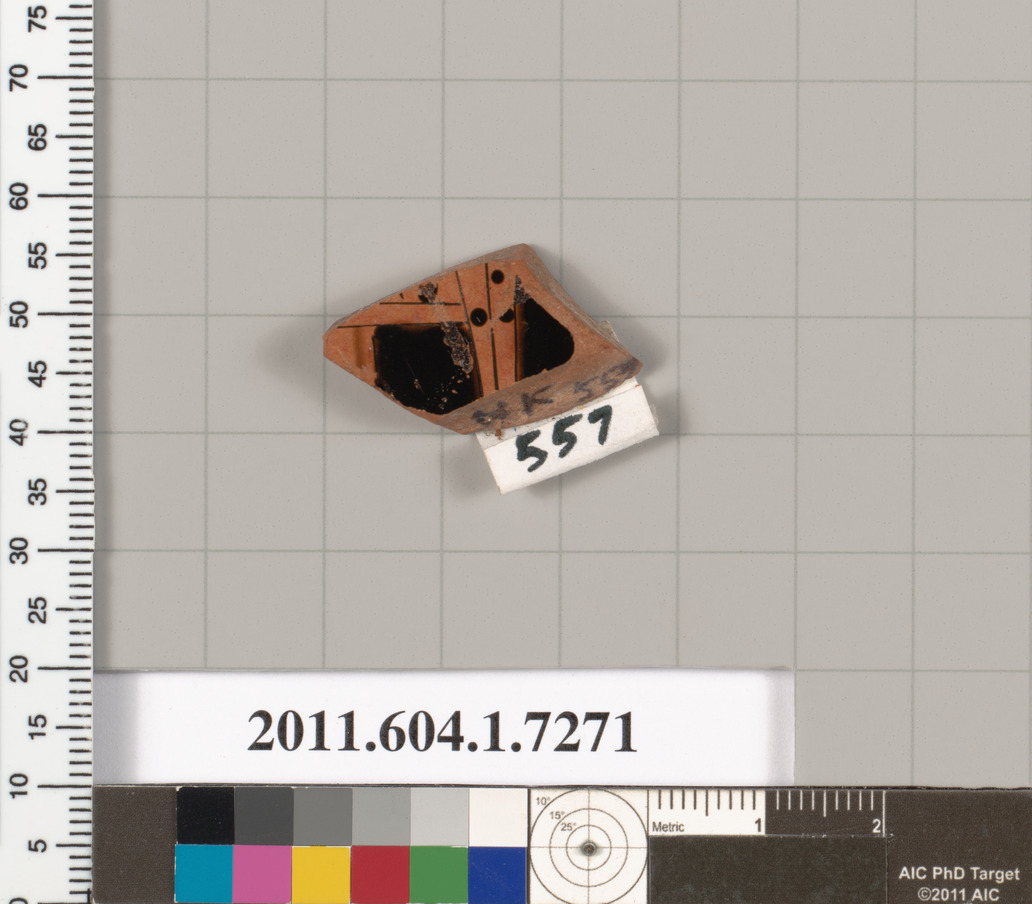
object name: kylix fragment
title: Terracotta fragment of a kylix (drinking cup)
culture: greek, attic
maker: makron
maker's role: artist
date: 500-480 BCE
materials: terracotta